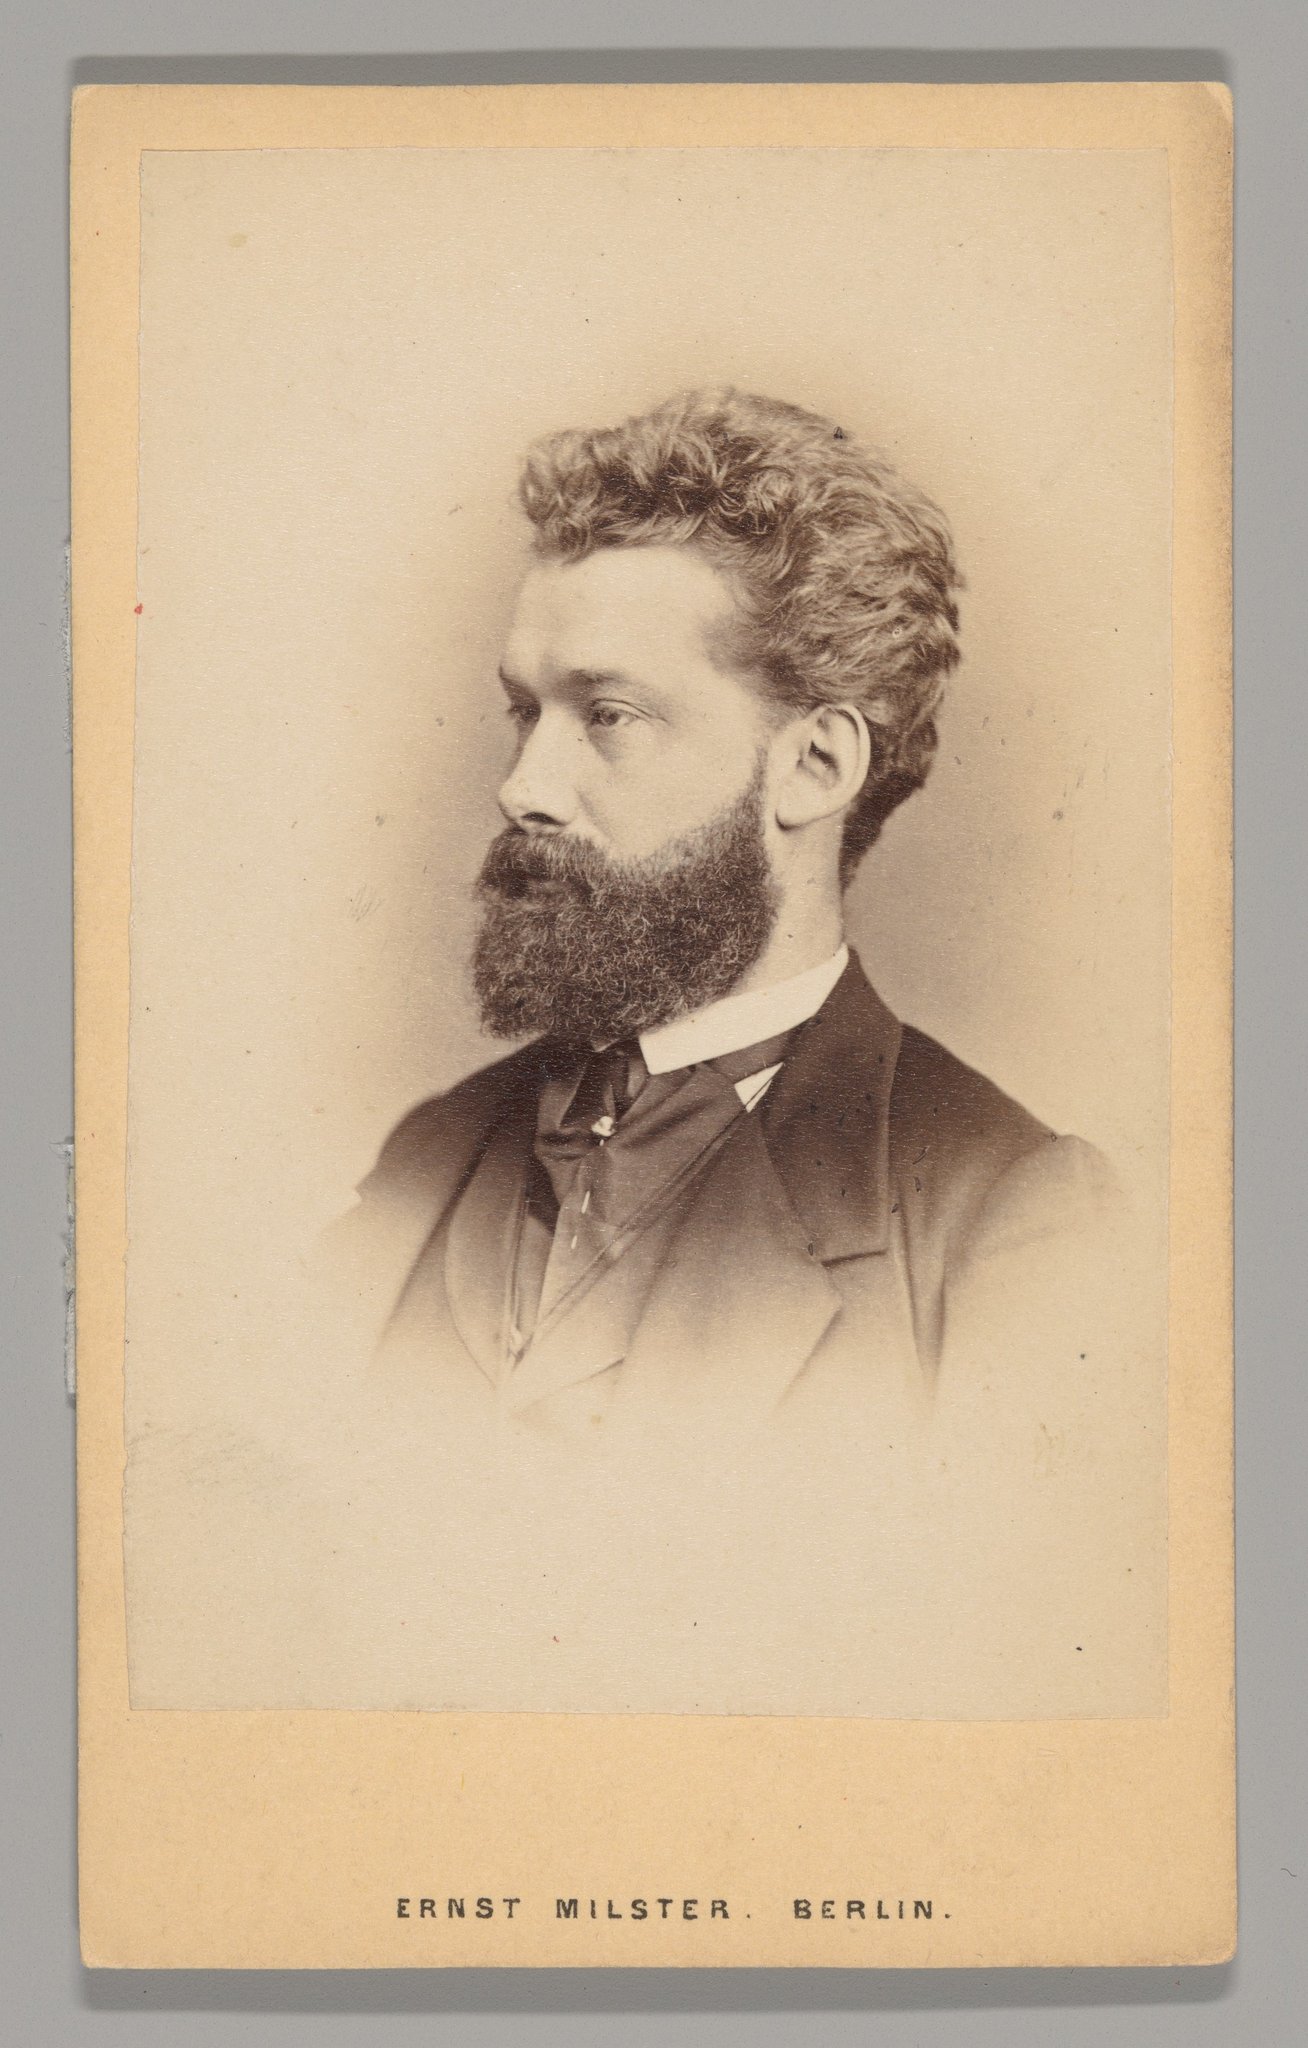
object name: carte de visite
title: Franz Heyerheim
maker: ernst milster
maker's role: artist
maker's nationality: german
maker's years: 1835-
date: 1860-1869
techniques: albumen silver print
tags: men,portraits,profiles